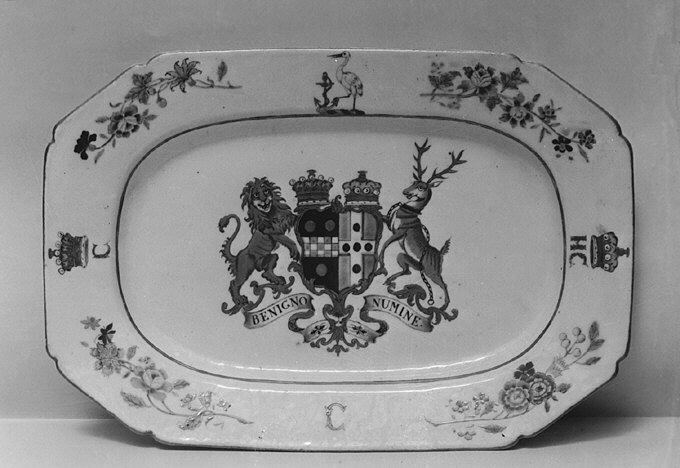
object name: platter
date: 1772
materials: hard paste porcelain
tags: birds,flowers,coat of arms